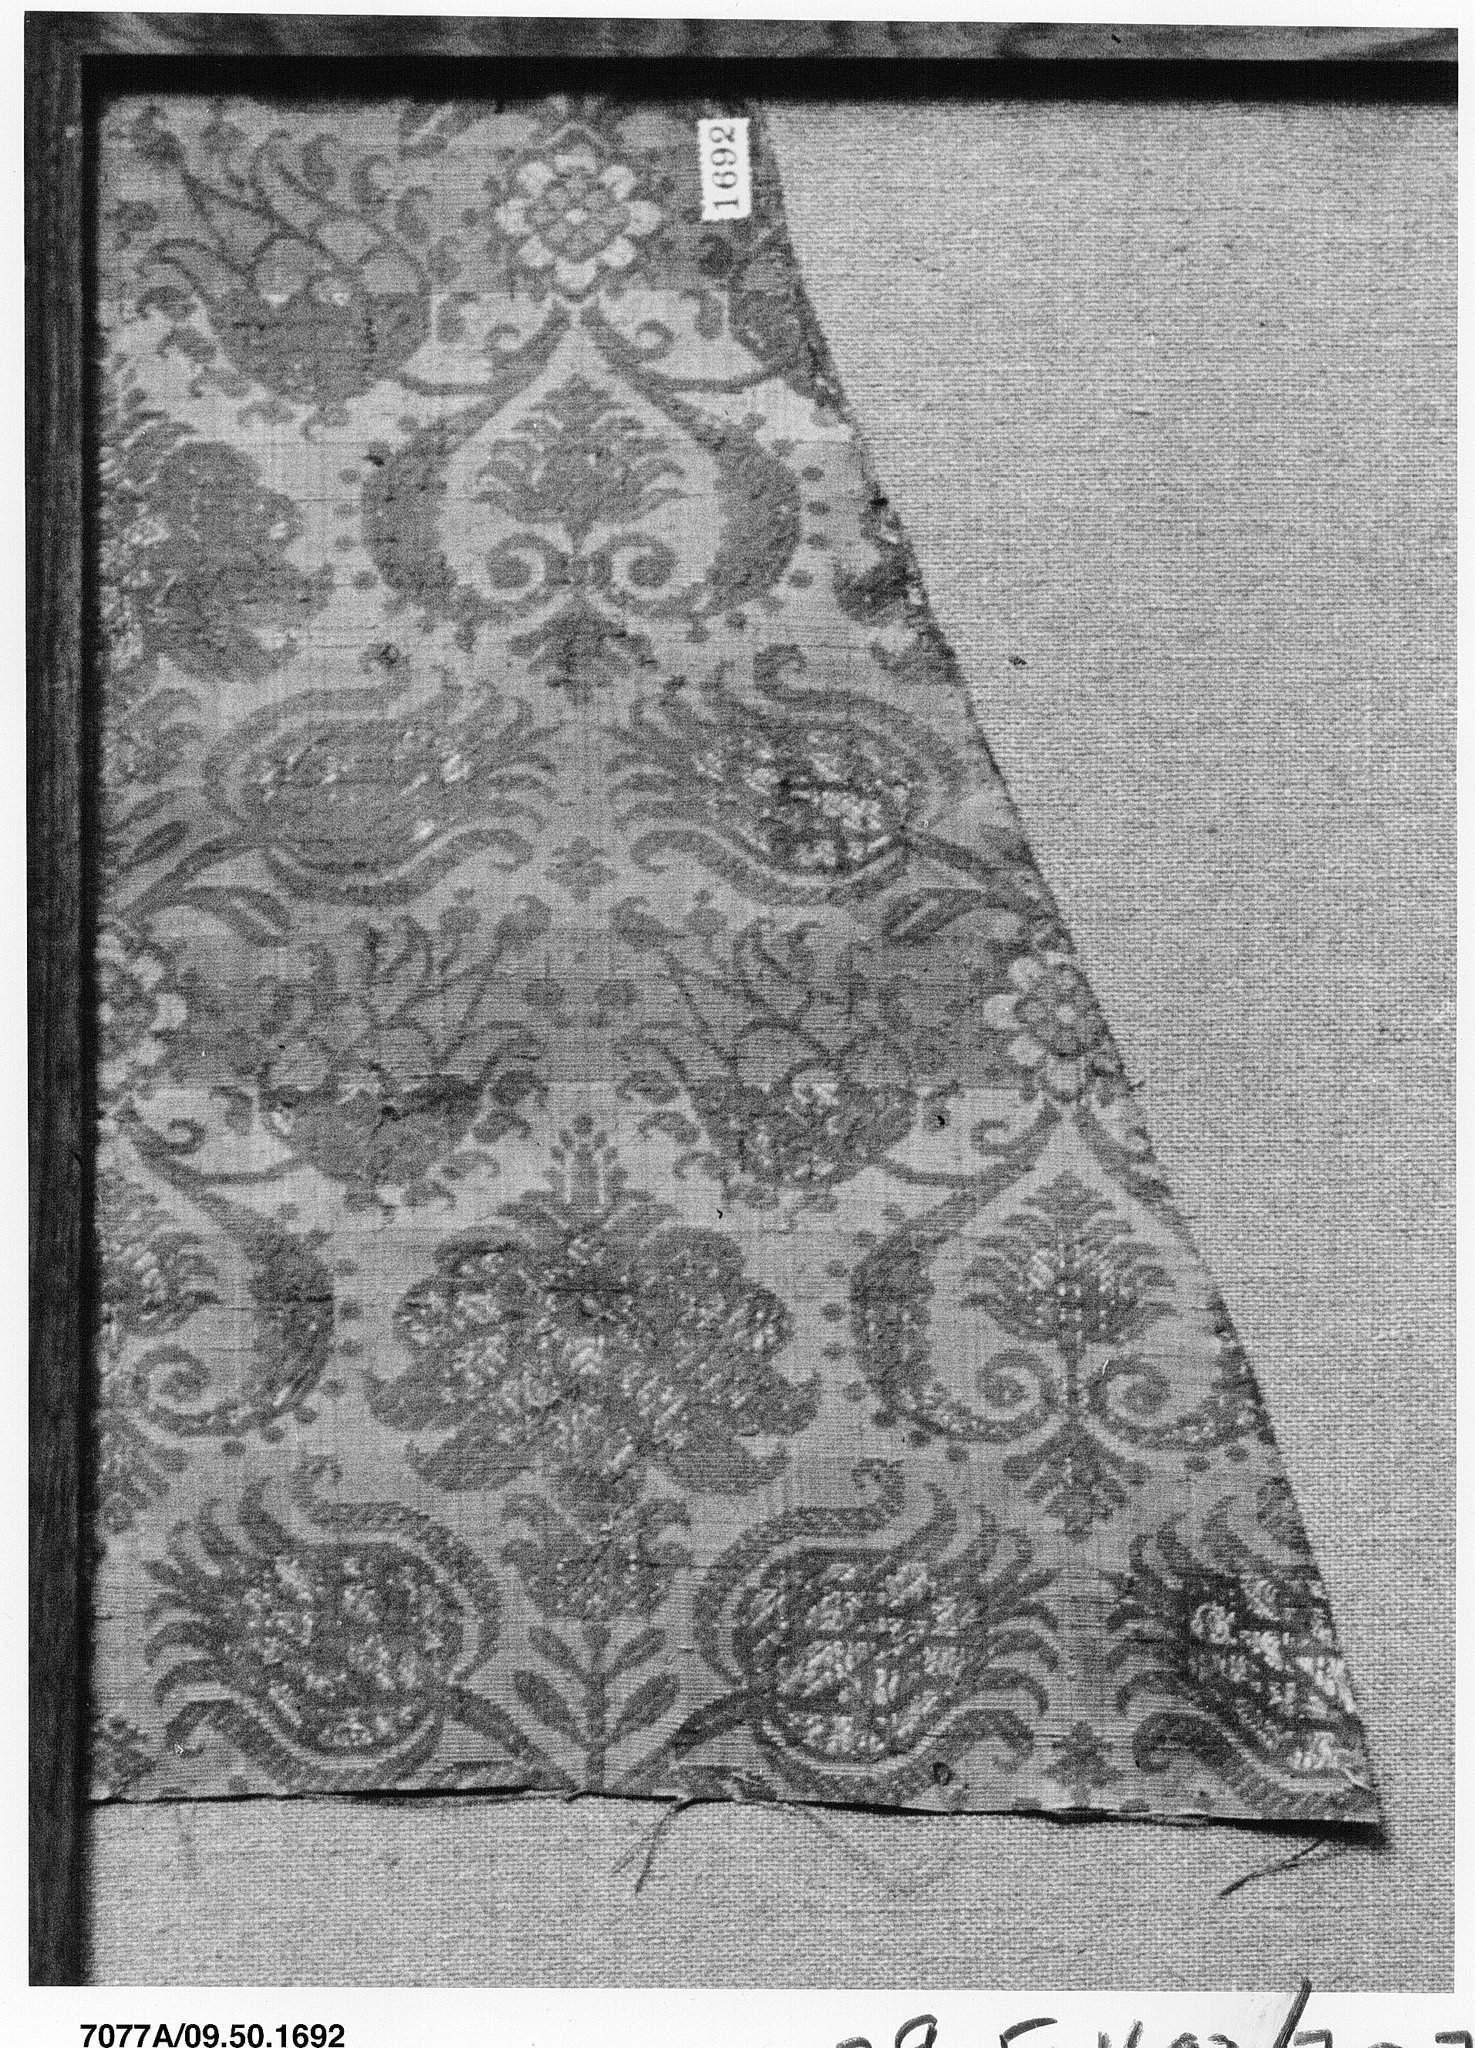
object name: piece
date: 1650-1660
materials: silk